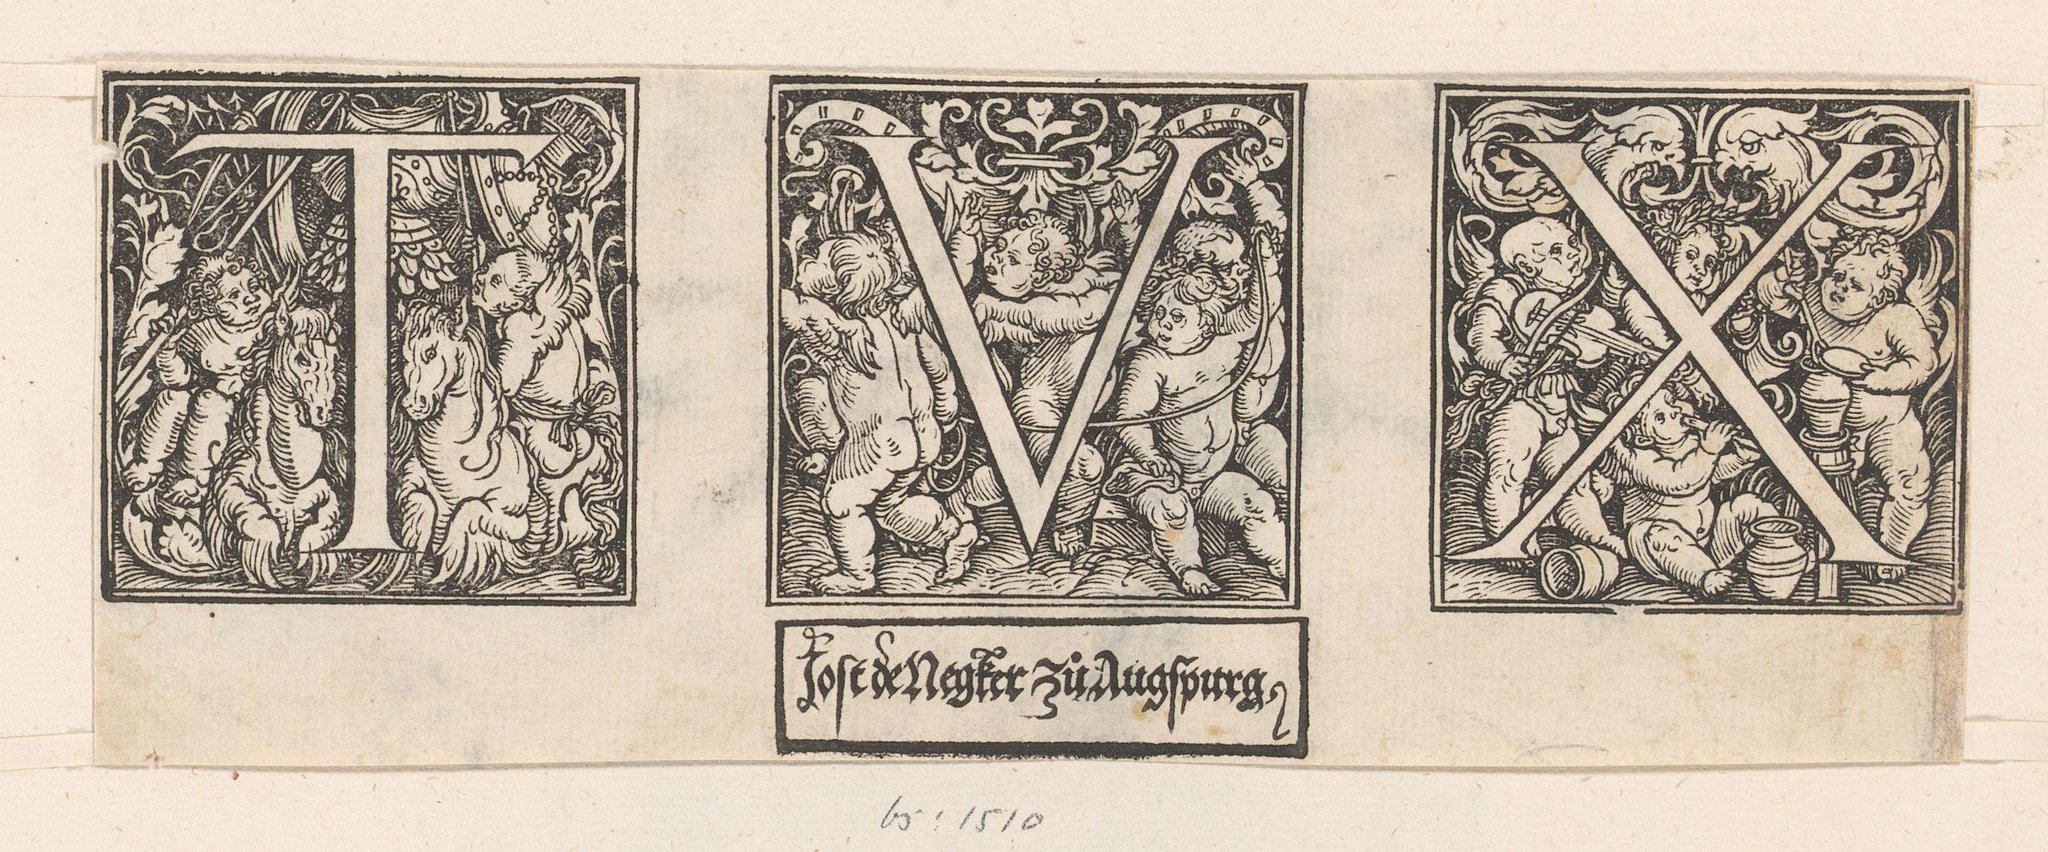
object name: print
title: Latijns alfabet met putti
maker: jost de negker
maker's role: print maker, printer, publisher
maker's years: 1485-1544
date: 1521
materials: paper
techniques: woodcut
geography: augsburg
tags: initial, cupids: 'amores', 'amoretti', 'putti'